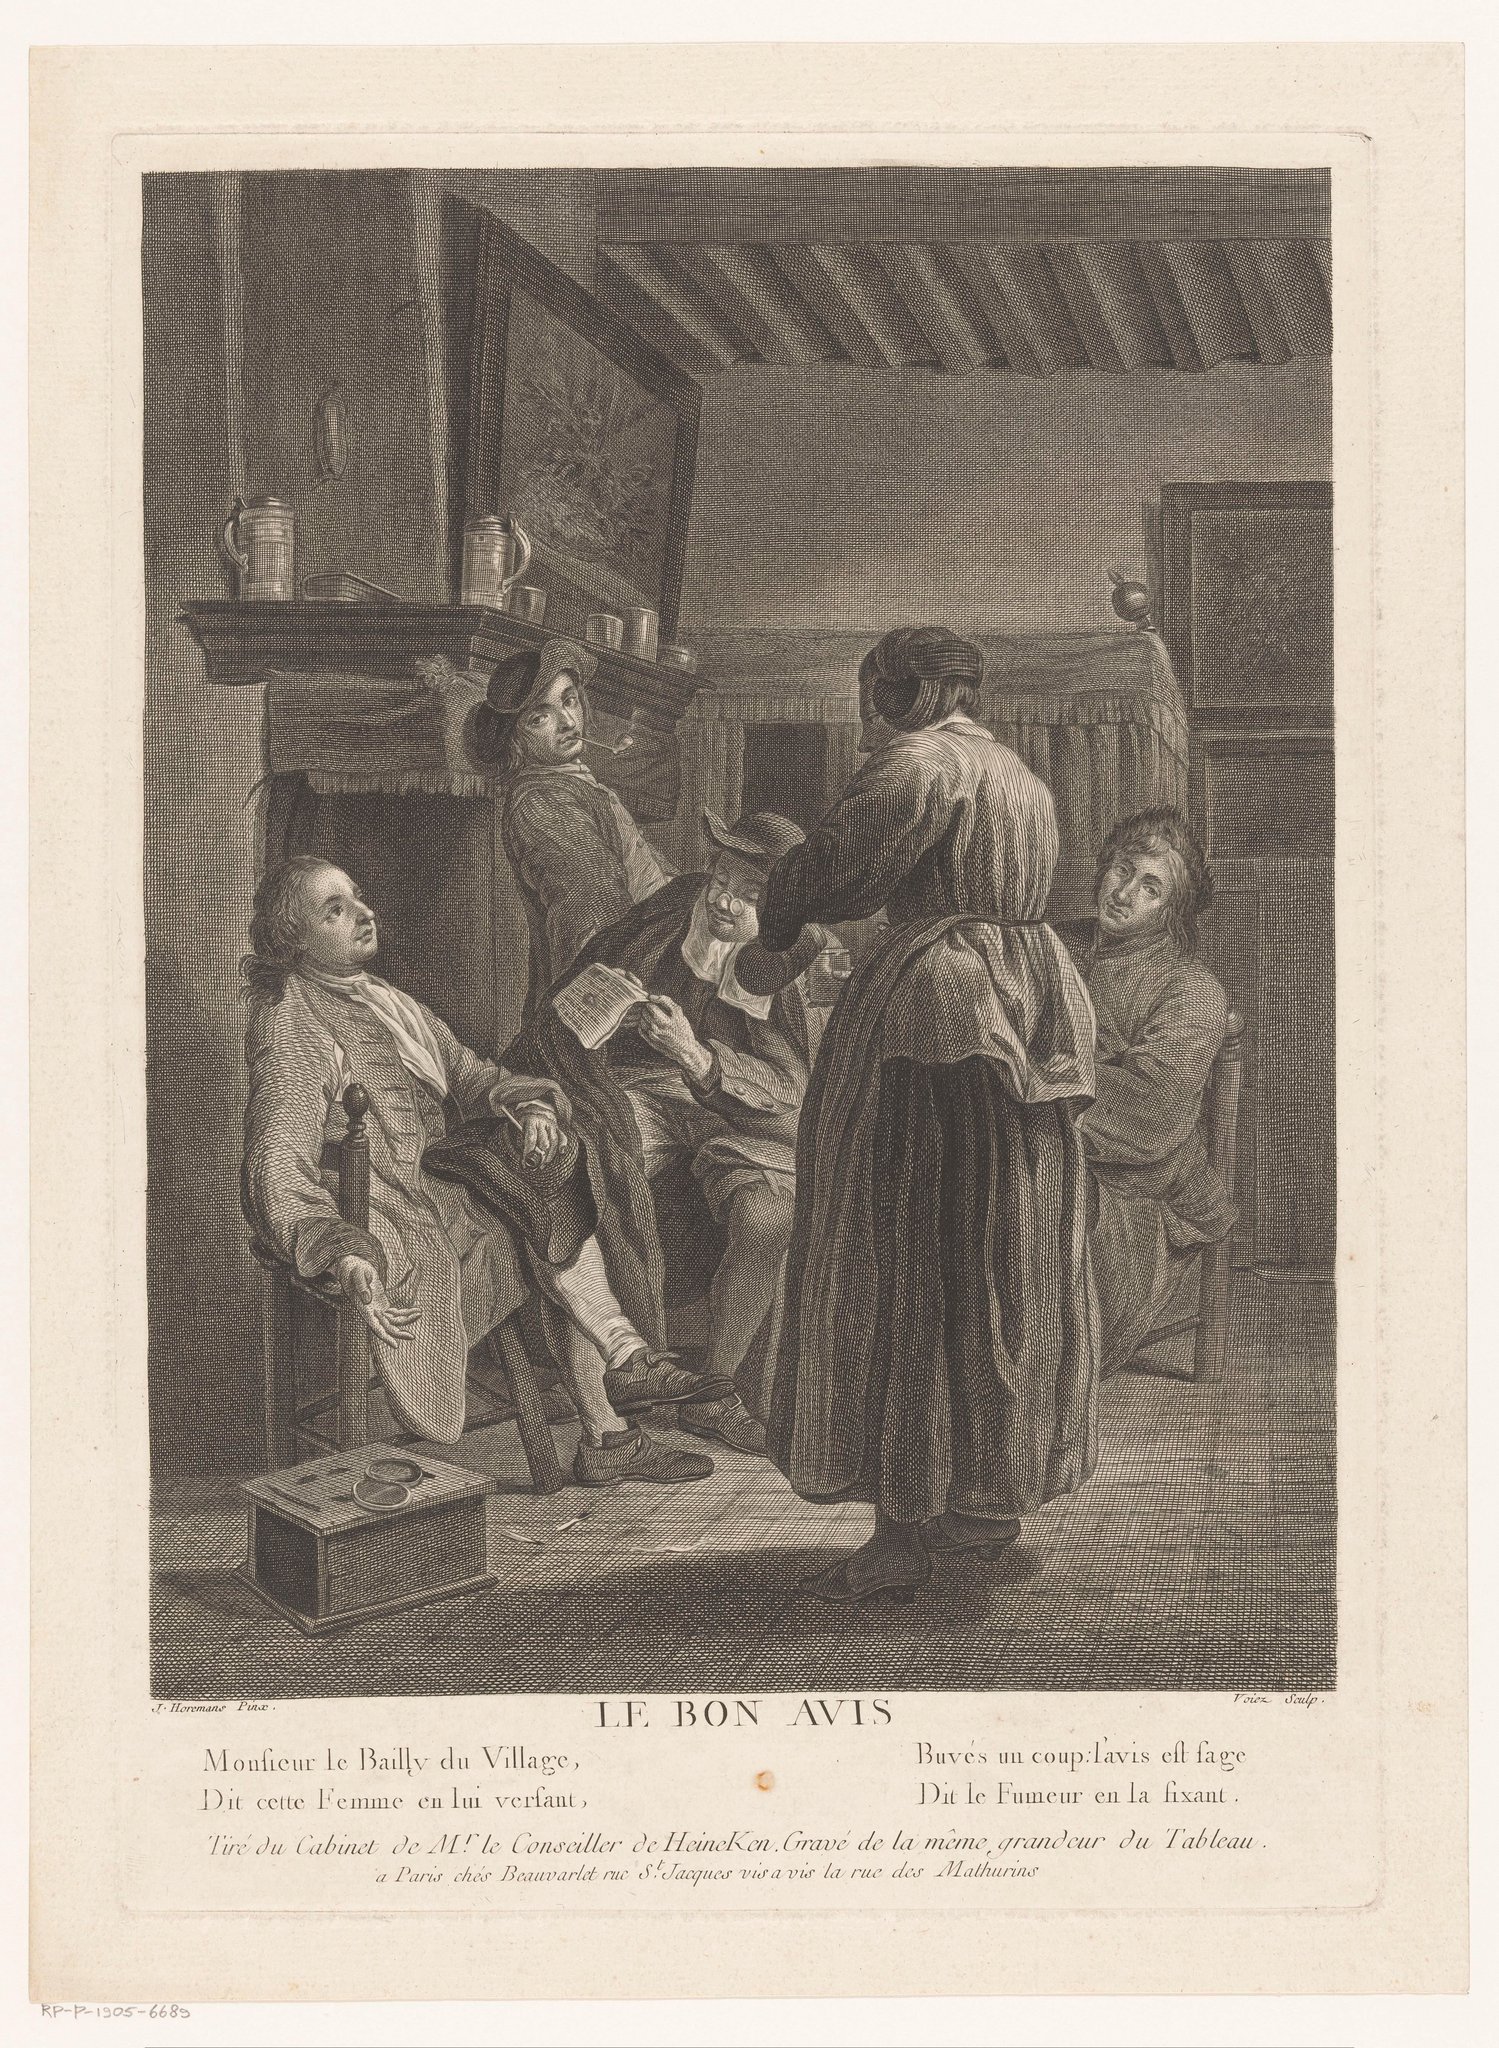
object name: print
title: Le Bon Avis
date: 1752-1779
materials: paper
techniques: engraving, etching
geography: paris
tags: interior of the house, beer, ale, maid ~ house personnel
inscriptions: collector's mark: Lugt 2228